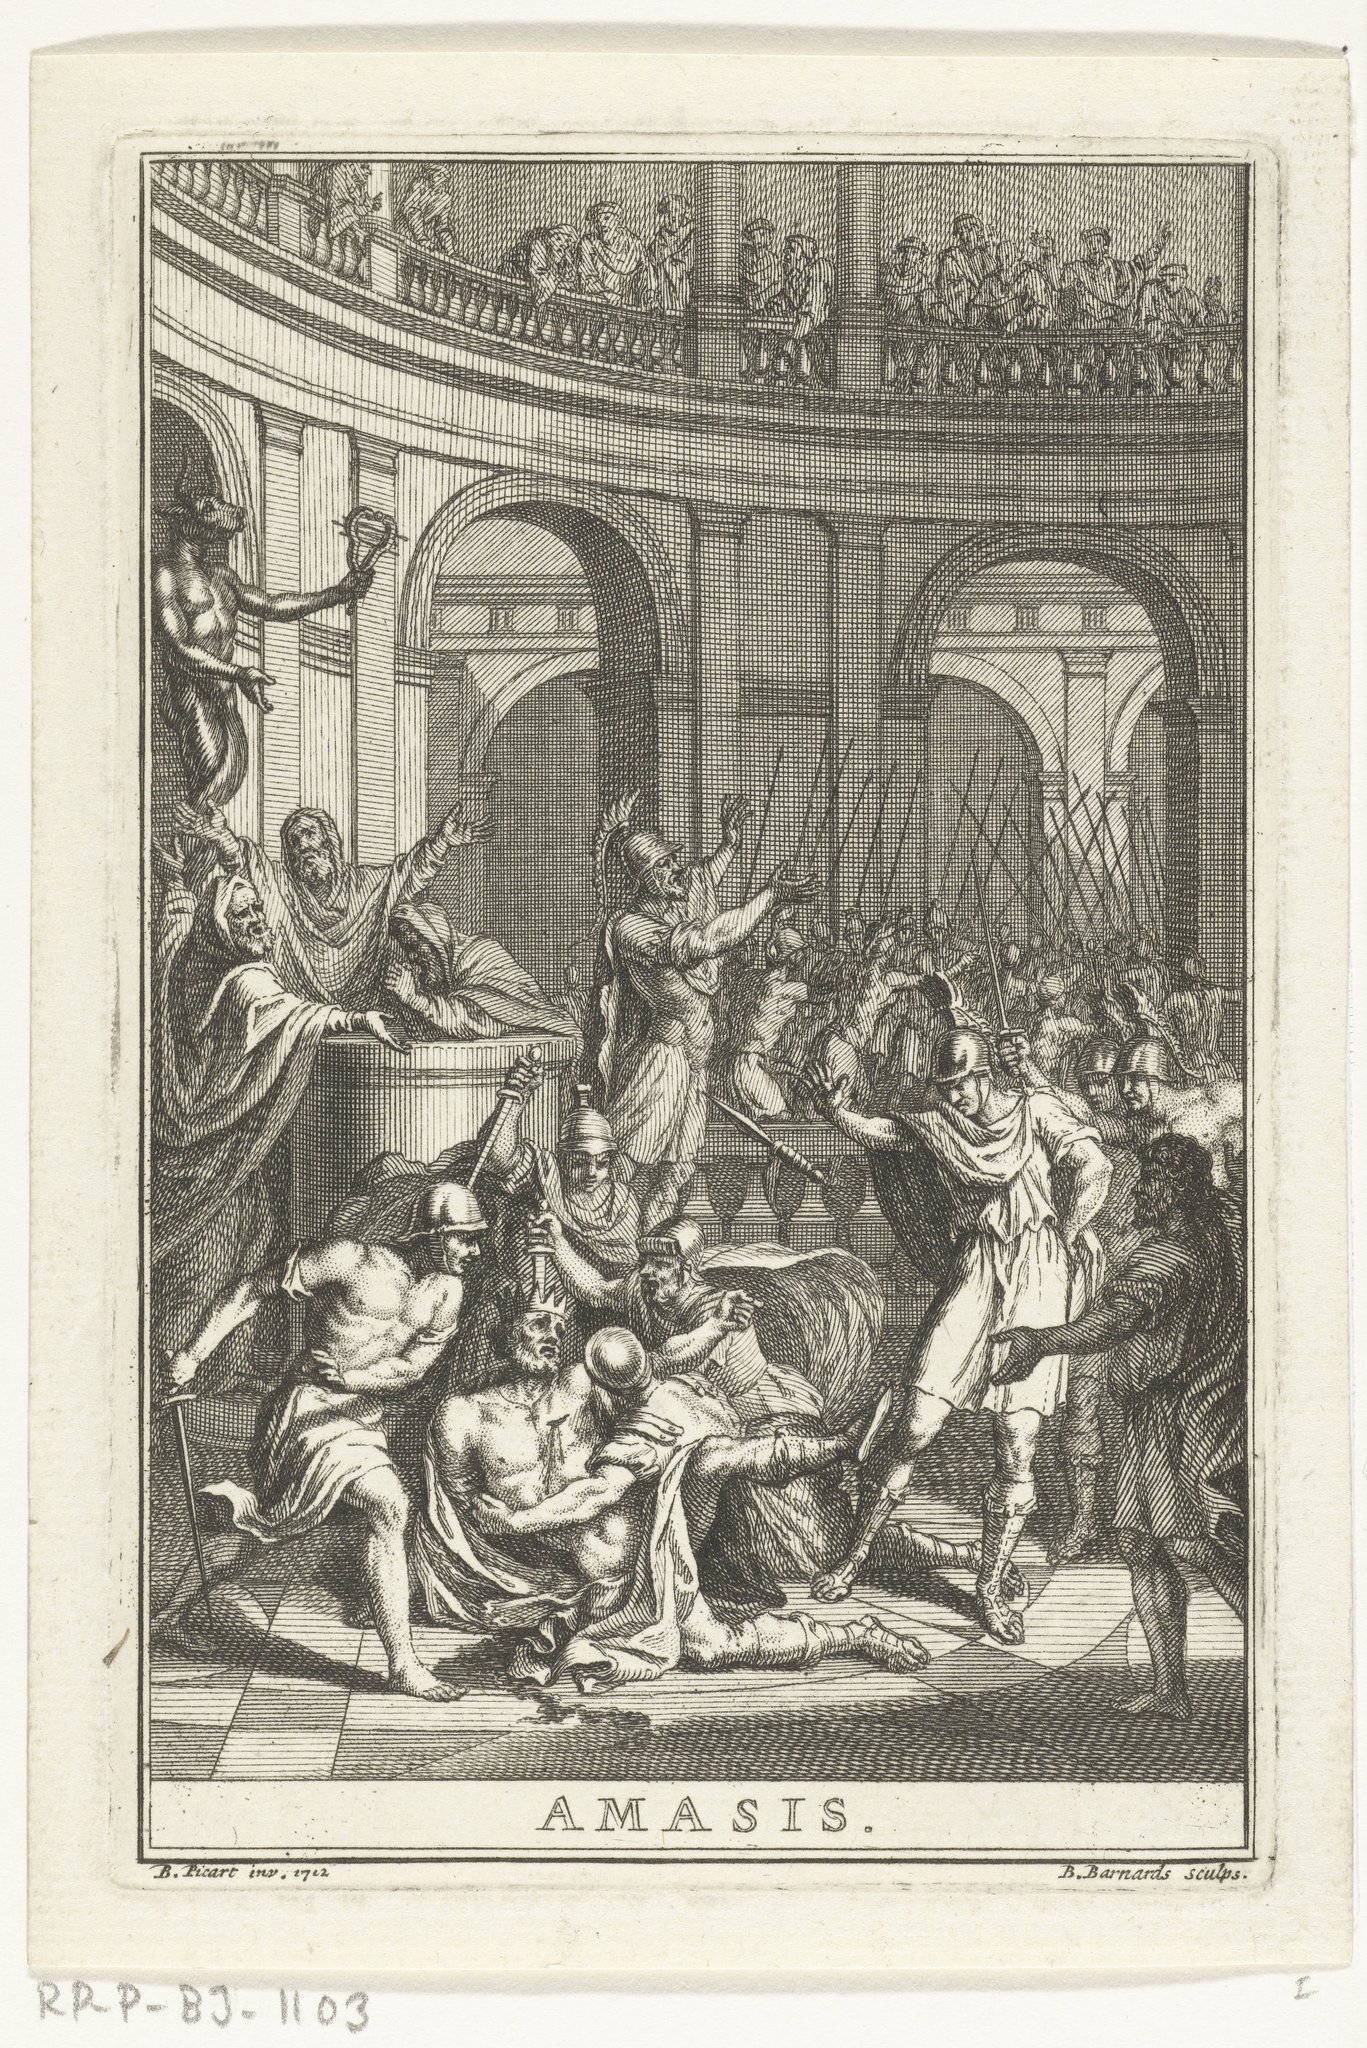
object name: titelblad, titelpagina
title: Titelpagina voor François Joseph de Lagrange Chancel "Amasis, tragedie"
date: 1711-1737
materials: paper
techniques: engraving, etching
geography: amsterdam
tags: murder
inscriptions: collector's mark: Lugt 2228, collector's mark: Lugt 240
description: In het koninklijk paleis van Egypte wordt de koning neergestoken. Hij ligt op de grond en wijst naar zijn moordenaar.